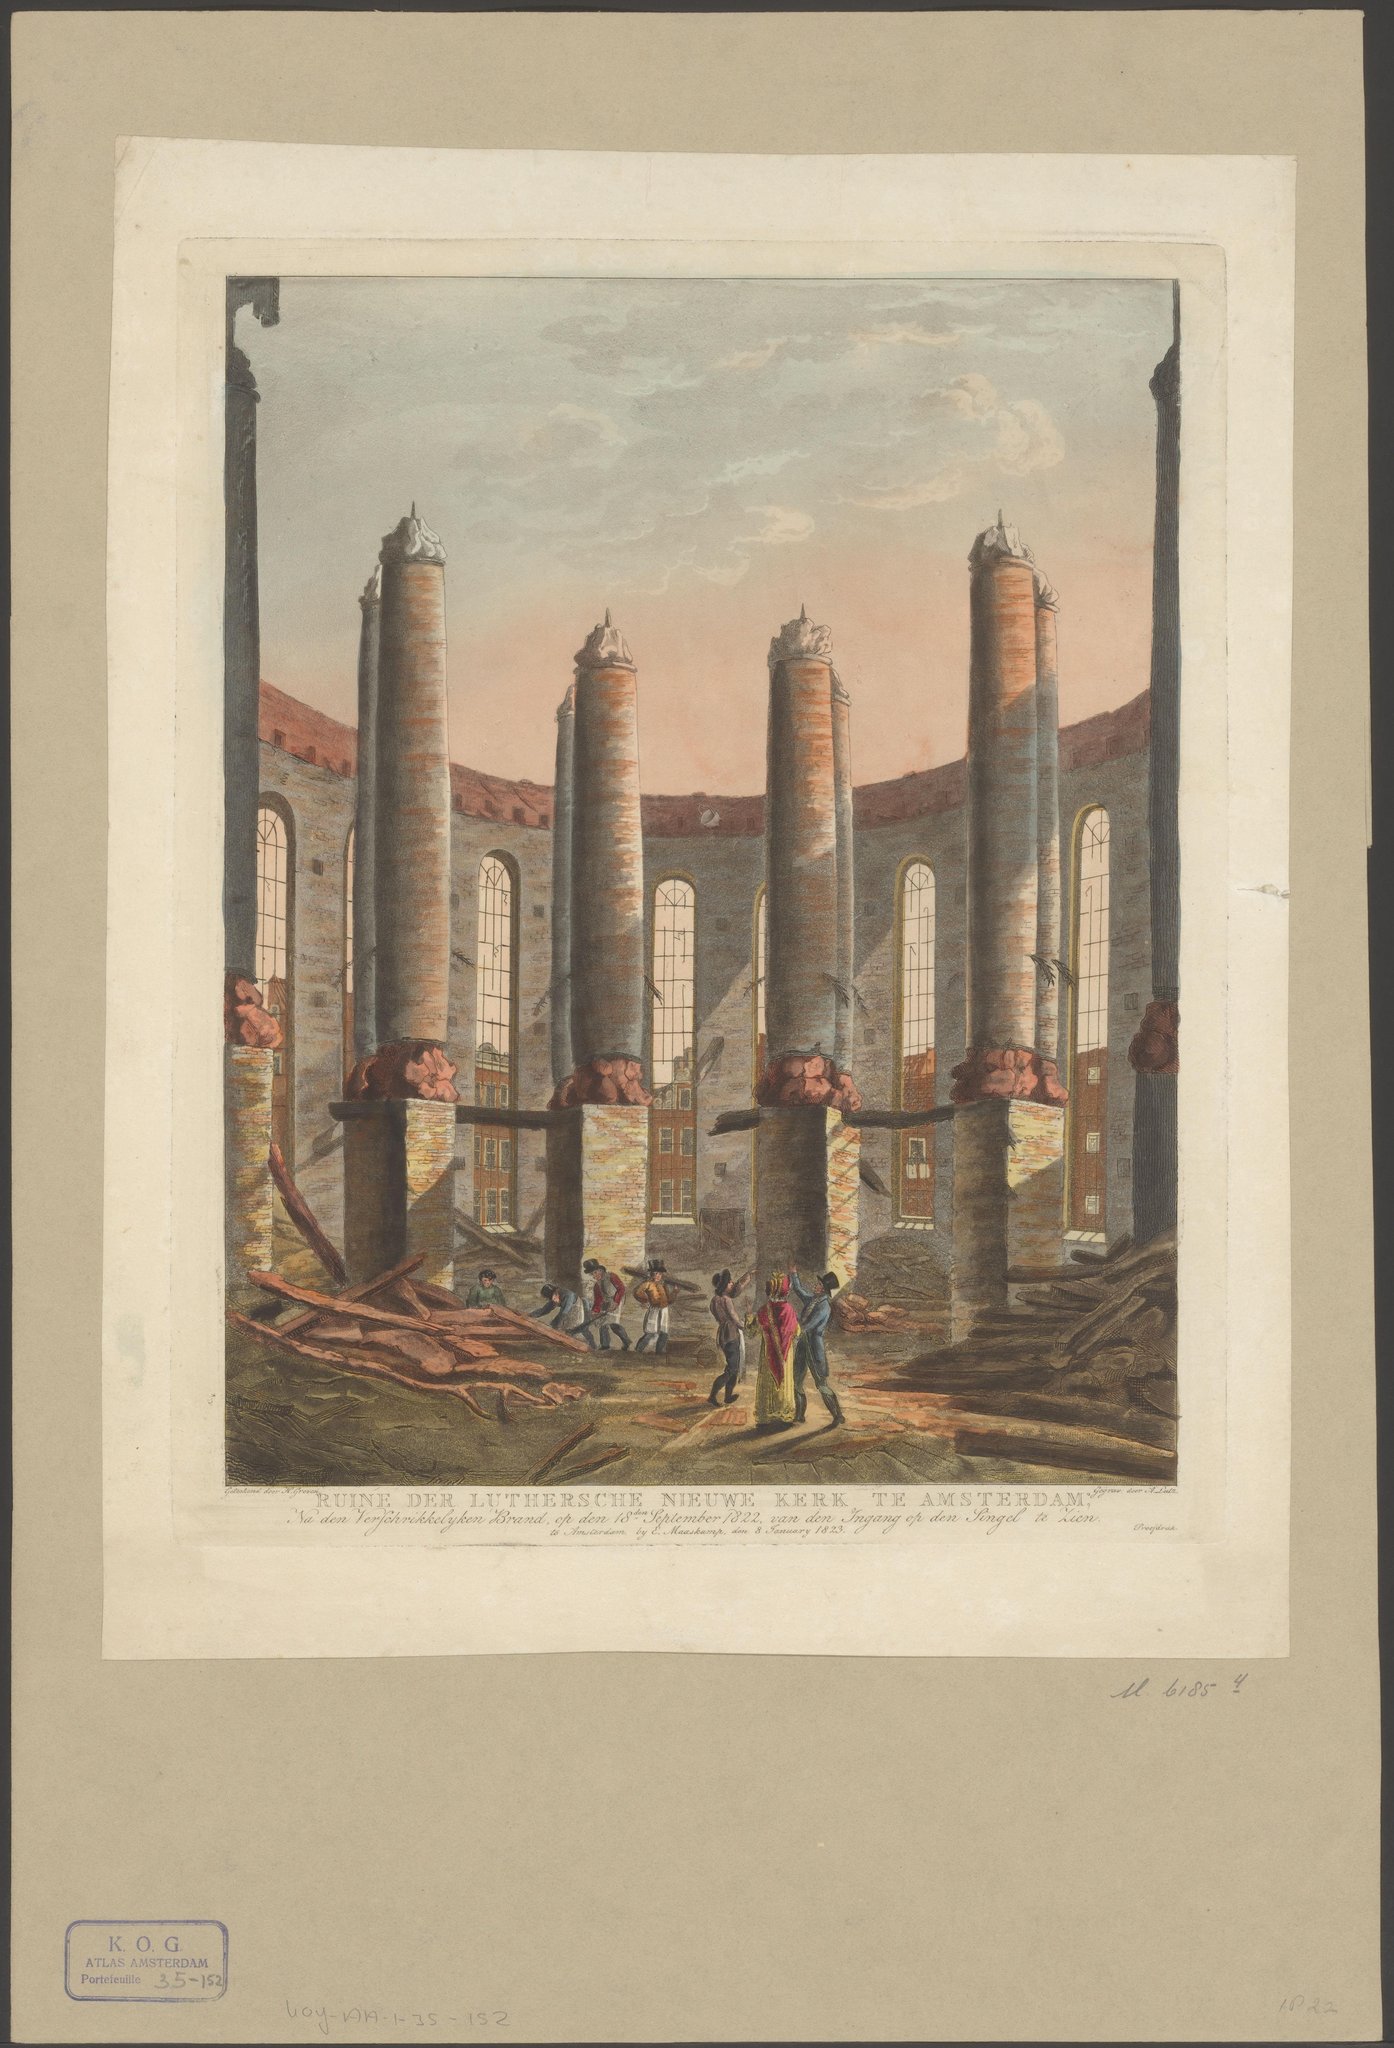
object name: print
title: Ruine der Luthersche Nieuwe Kerk te Amsterdam, Na den Verschrikkelyken Brand, op den 18den September 1822, van den Ingang op den Singel te Zien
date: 1823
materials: paper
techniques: aquatint, etching, hand coloring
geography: amsterdam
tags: on fire, ablaze, ruin of a building ~ architecture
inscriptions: collector's mark: Lugt 1641b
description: Gezicht op de ruïne van de Nieuwe Lutherse Kerk op het Singel te Amsterdam, na de brand op 18 september 1822. Onderwerpsrubriek binnen de Atlas Amsterdam: Kerkwezen: Ev. Lutherse Gemeente: 1822 Brand in de Nieuwe Luthersche Koepelkerk - Ruïne.